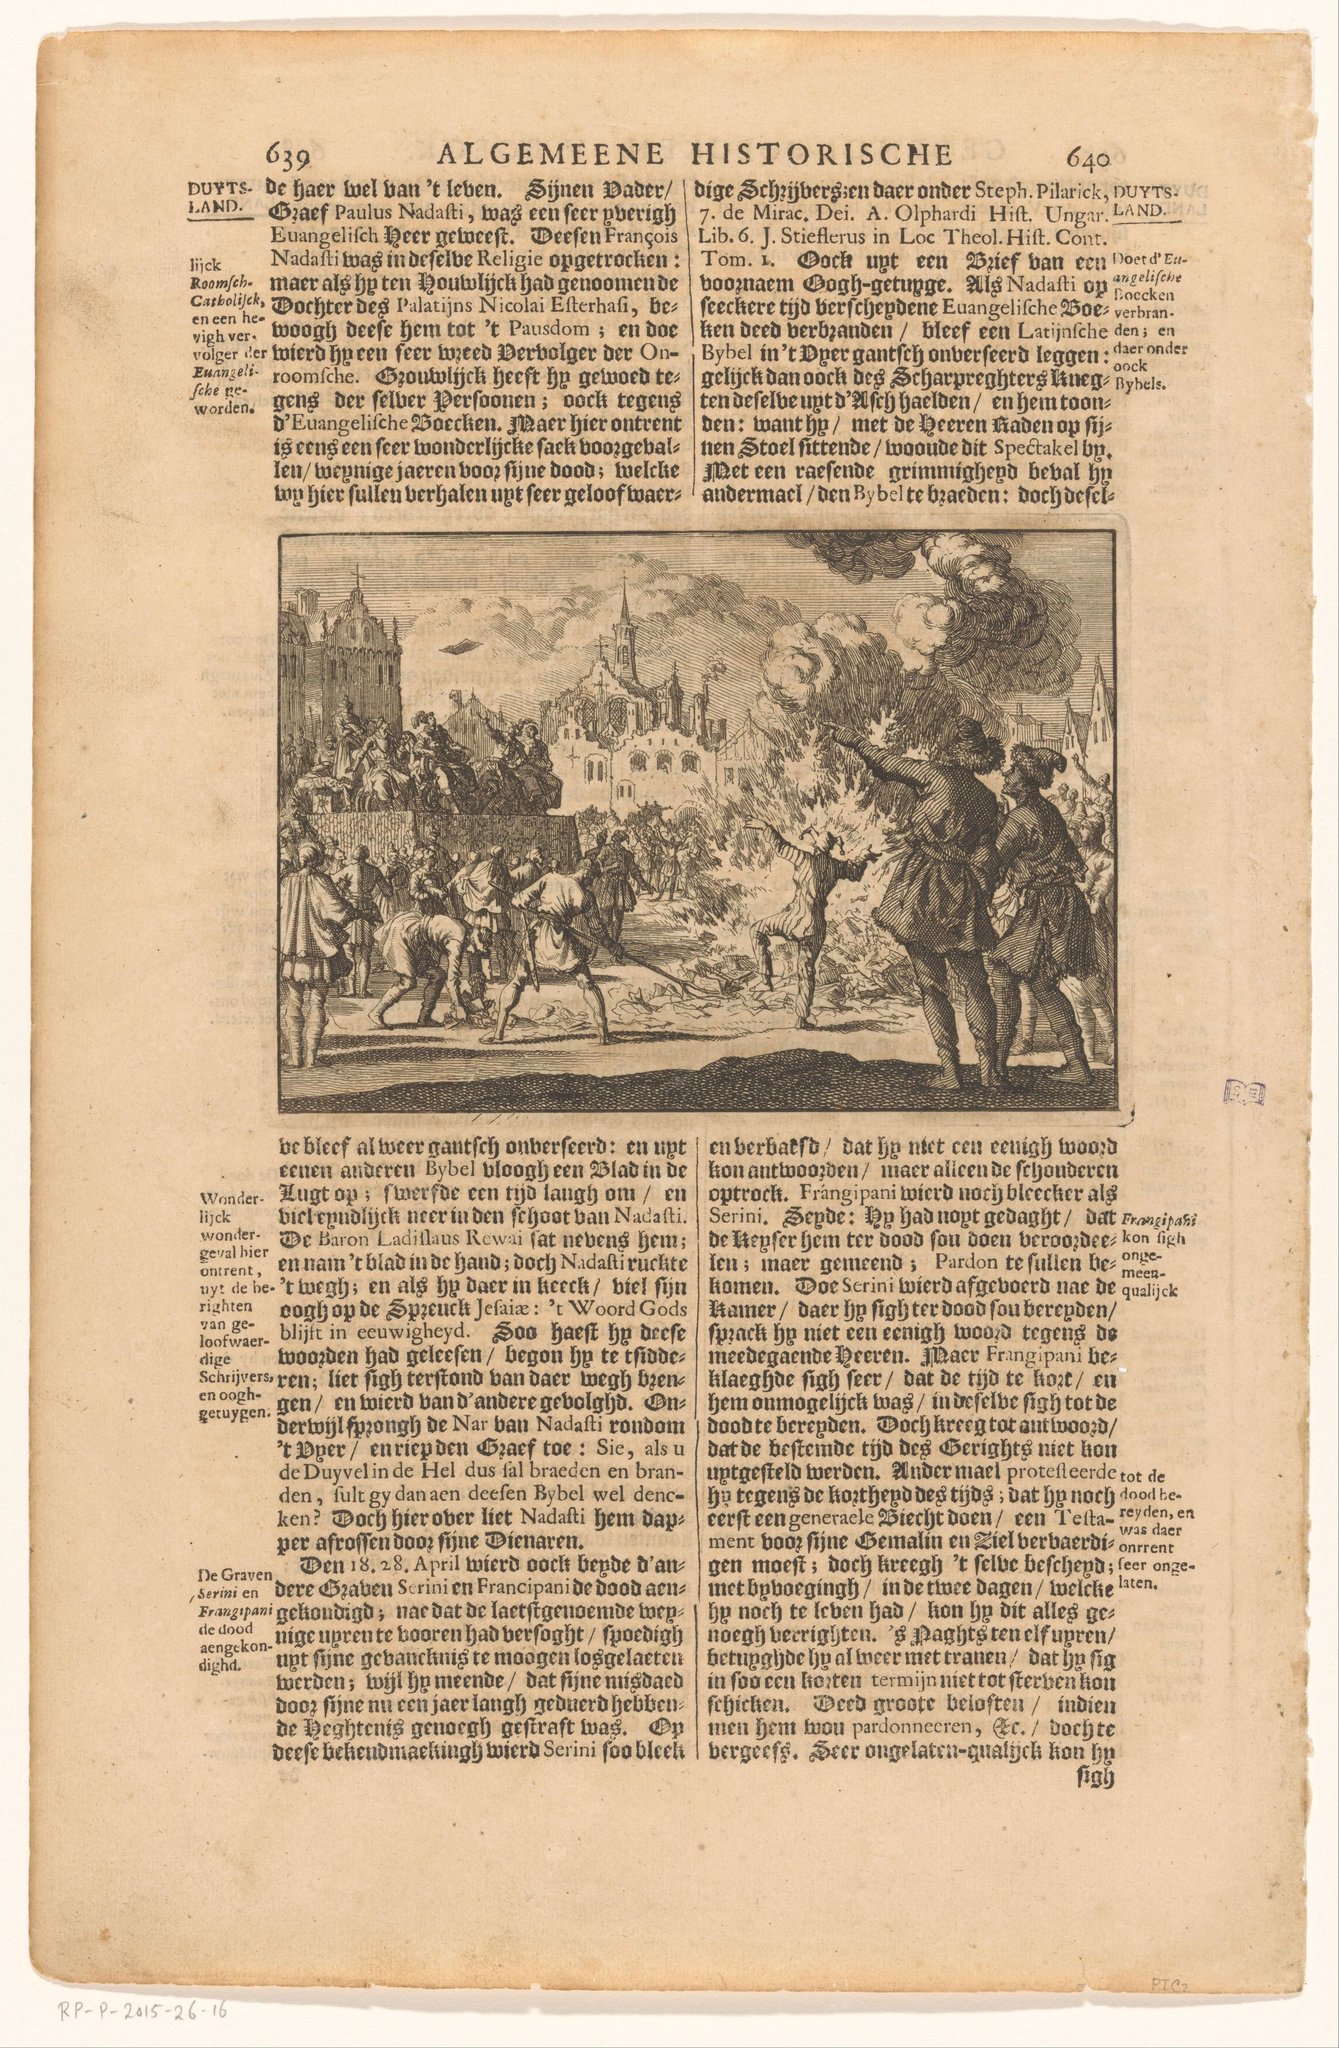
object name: print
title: Bijbelverbranding in Hongarije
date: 1689-1698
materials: paper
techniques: etching, letterpress printing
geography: leiden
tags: court jester, court fool, the bible as a book, burning of books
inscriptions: collector's mark: Lugt 2228, collector's mark: Lugt 4780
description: Bijbelverbranding op een plein, bekeken door graaf Franz Nadasti vanaf een podium. Volgens de overlevering kwam een bijbel ongeschonden uit het vuur en belandde een blad uit een andere bijbel op de schoot van de graaf. Kolomnummers 639 en 640 in linker- en rechter bovenhoek.